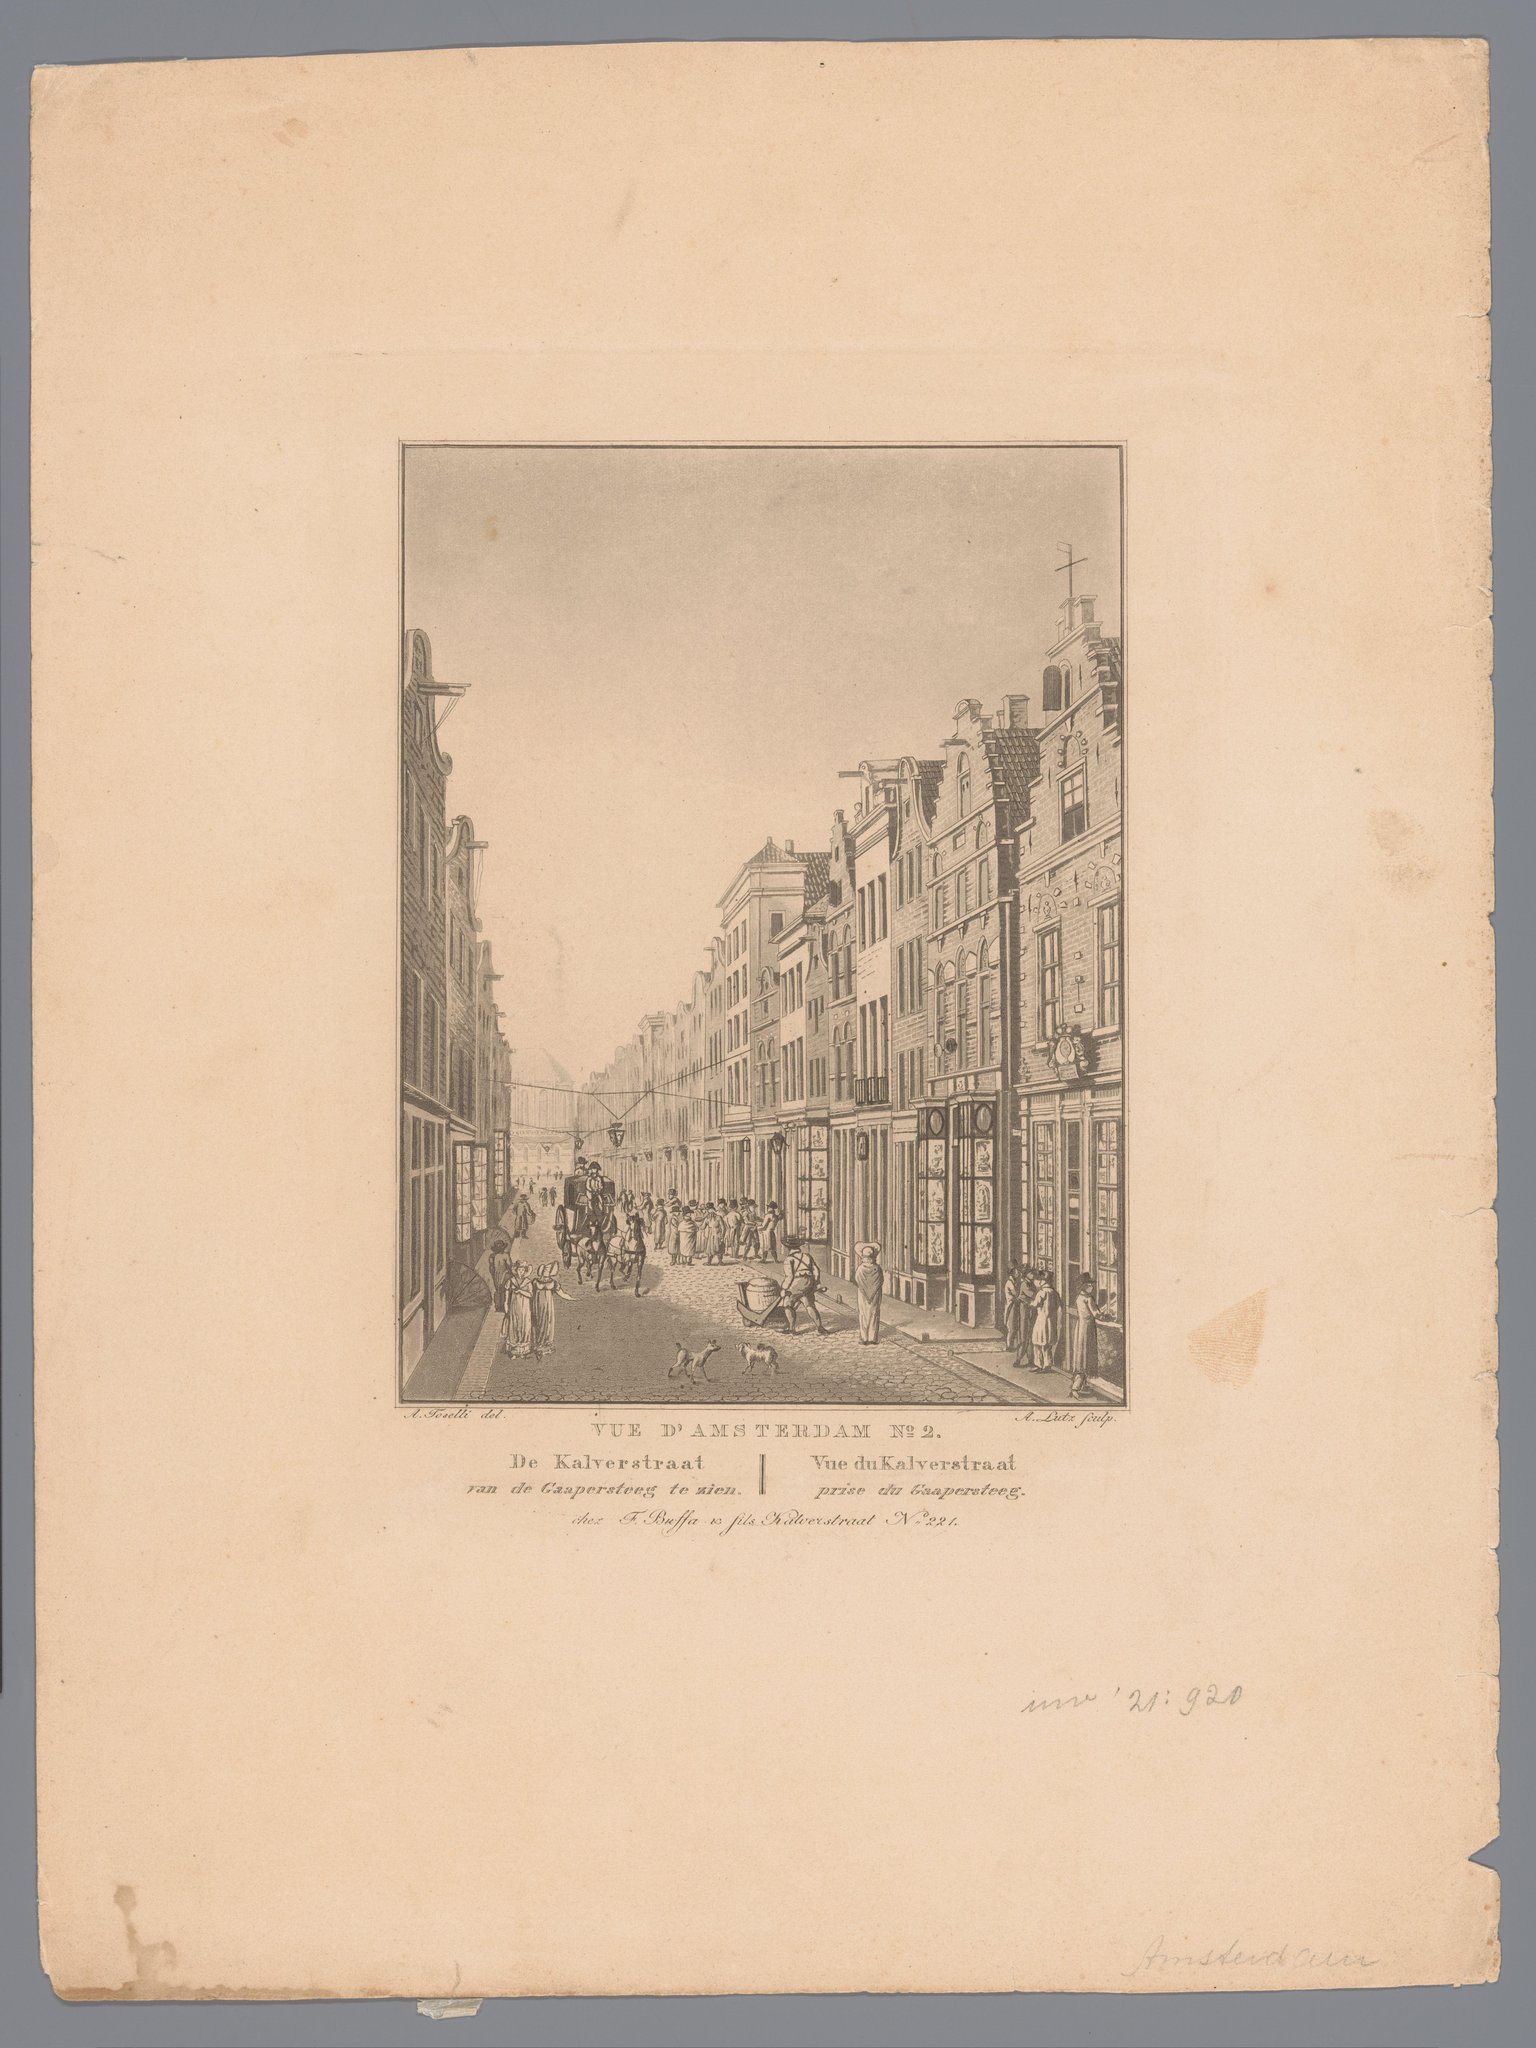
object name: print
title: Vue d'Amsterdam No 2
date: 1809-1822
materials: paper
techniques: aquatint, etching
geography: amsterdam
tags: house combined with shop, wheelbarrow, four-wheeled vehicle drawn by two animals, shop-window, show-window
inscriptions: collector's mark: Lugt 2233